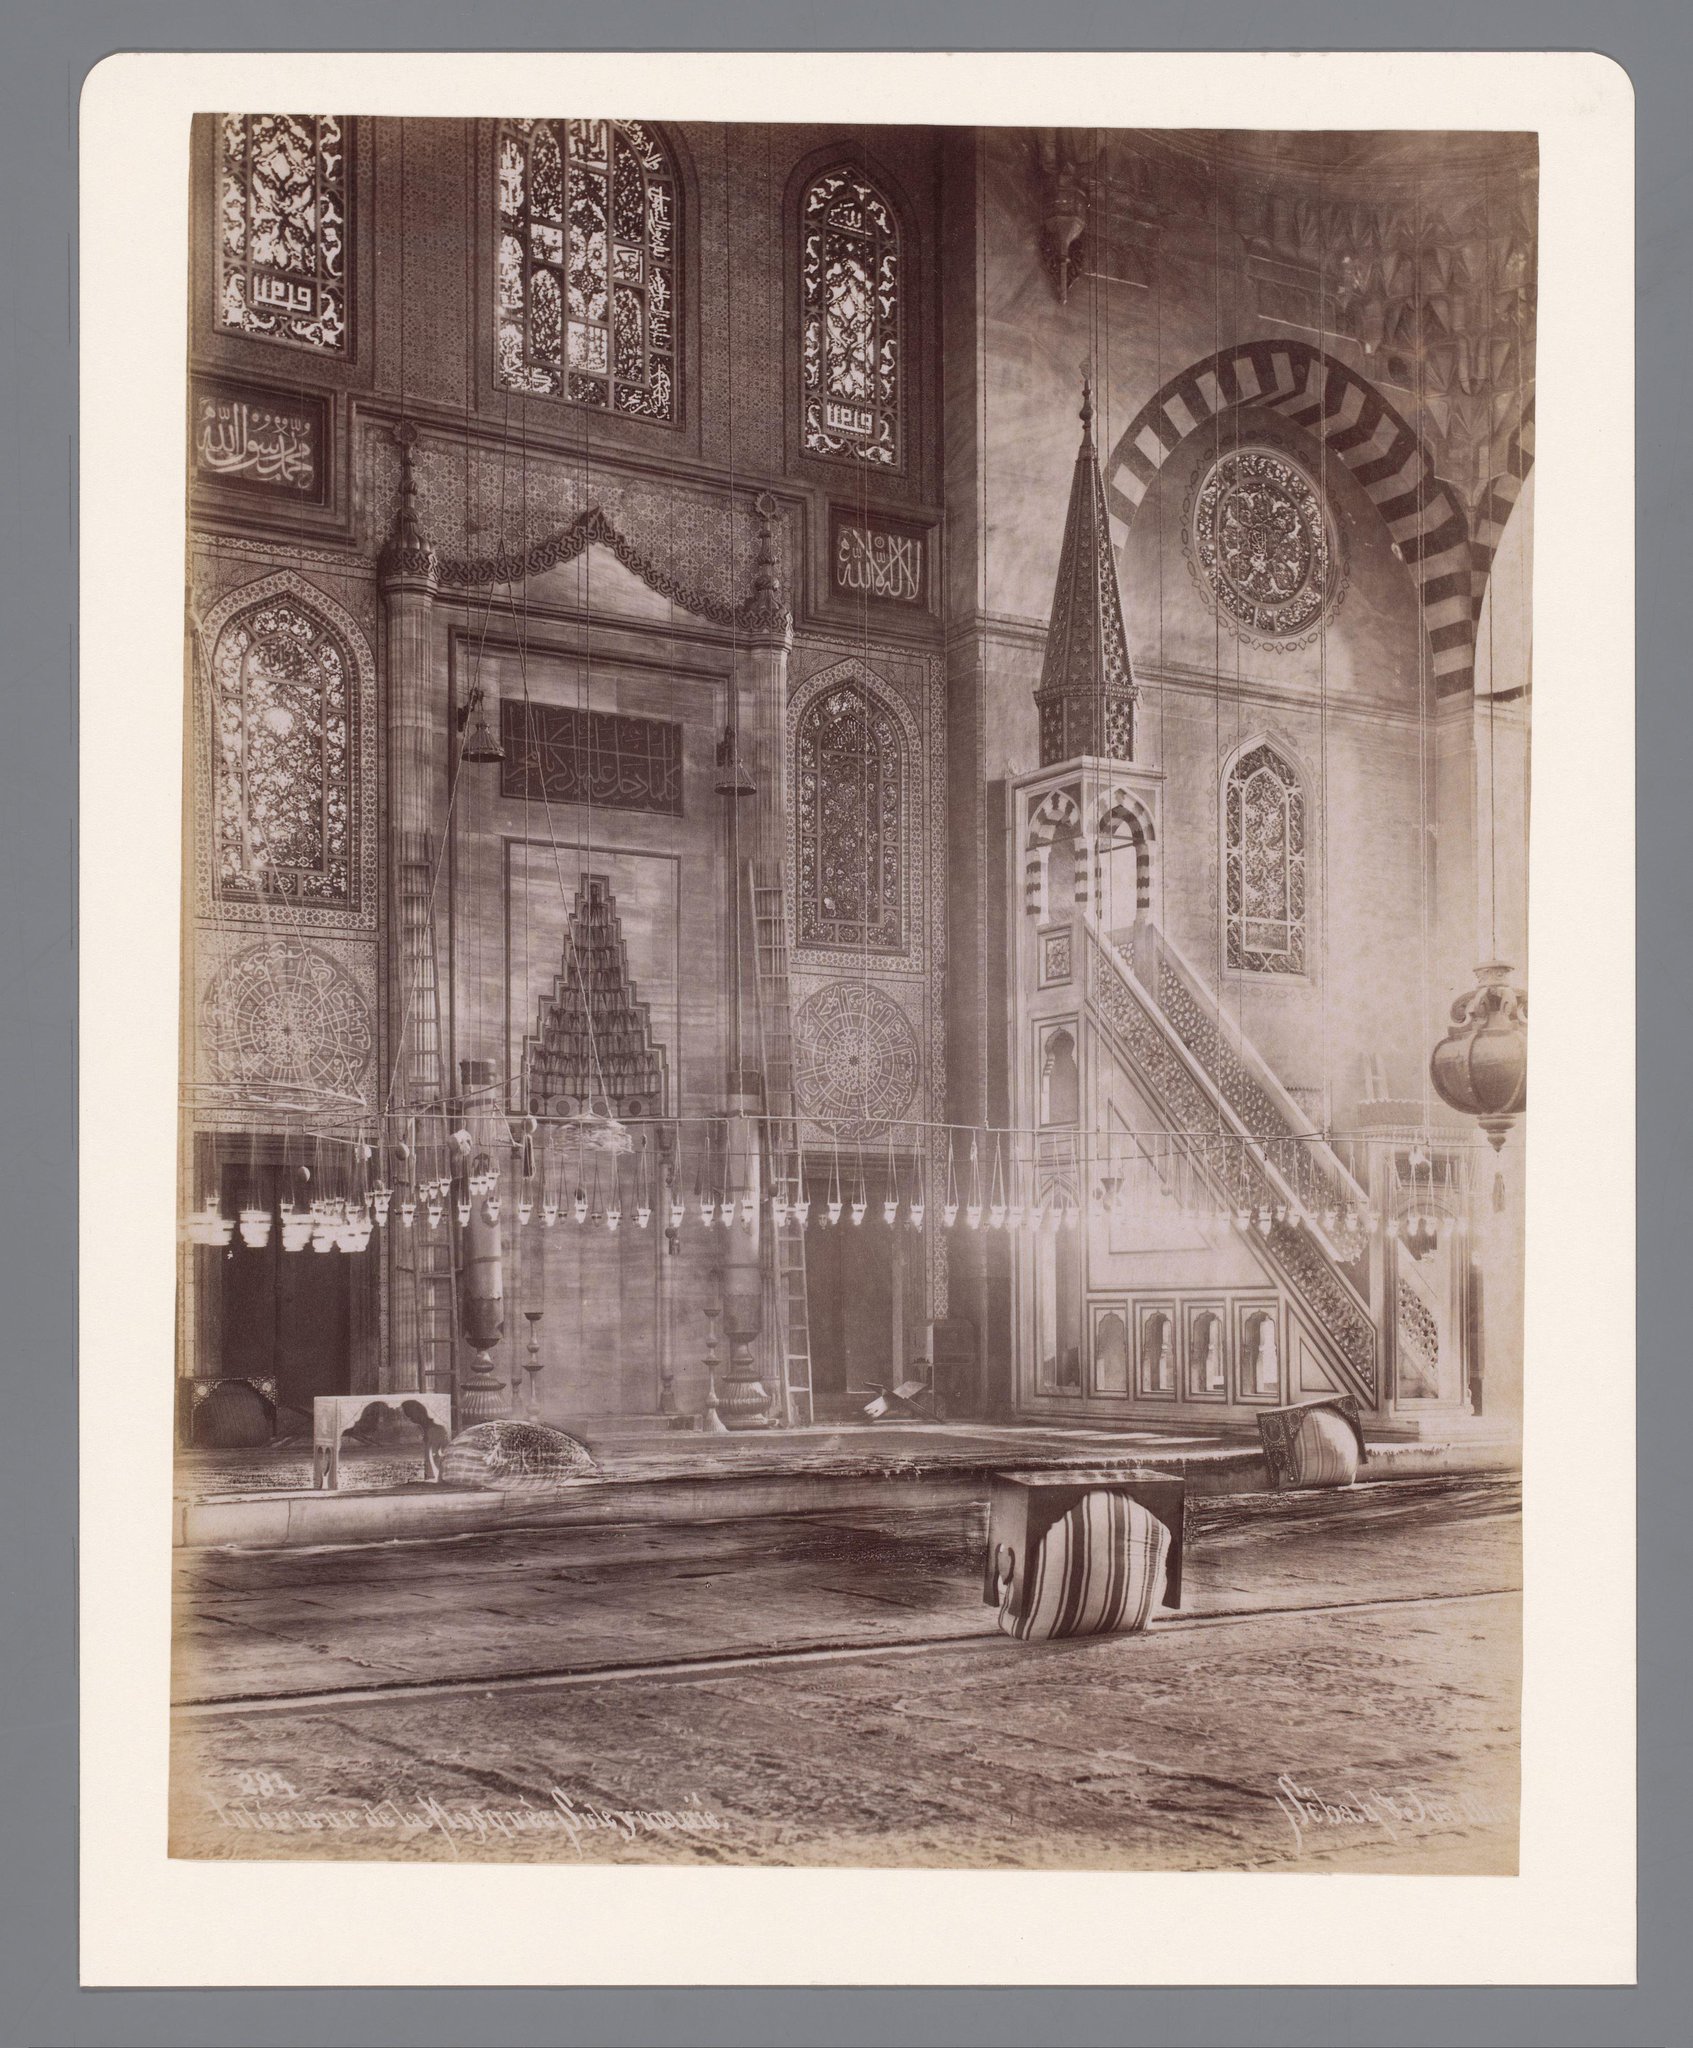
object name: photograph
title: Intérieur de la Mosquée Suleymanie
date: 1888-1900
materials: paper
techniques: albumen print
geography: istanbul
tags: temple, shrine ~ islam, mohammedanism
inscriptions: number: ‘284’